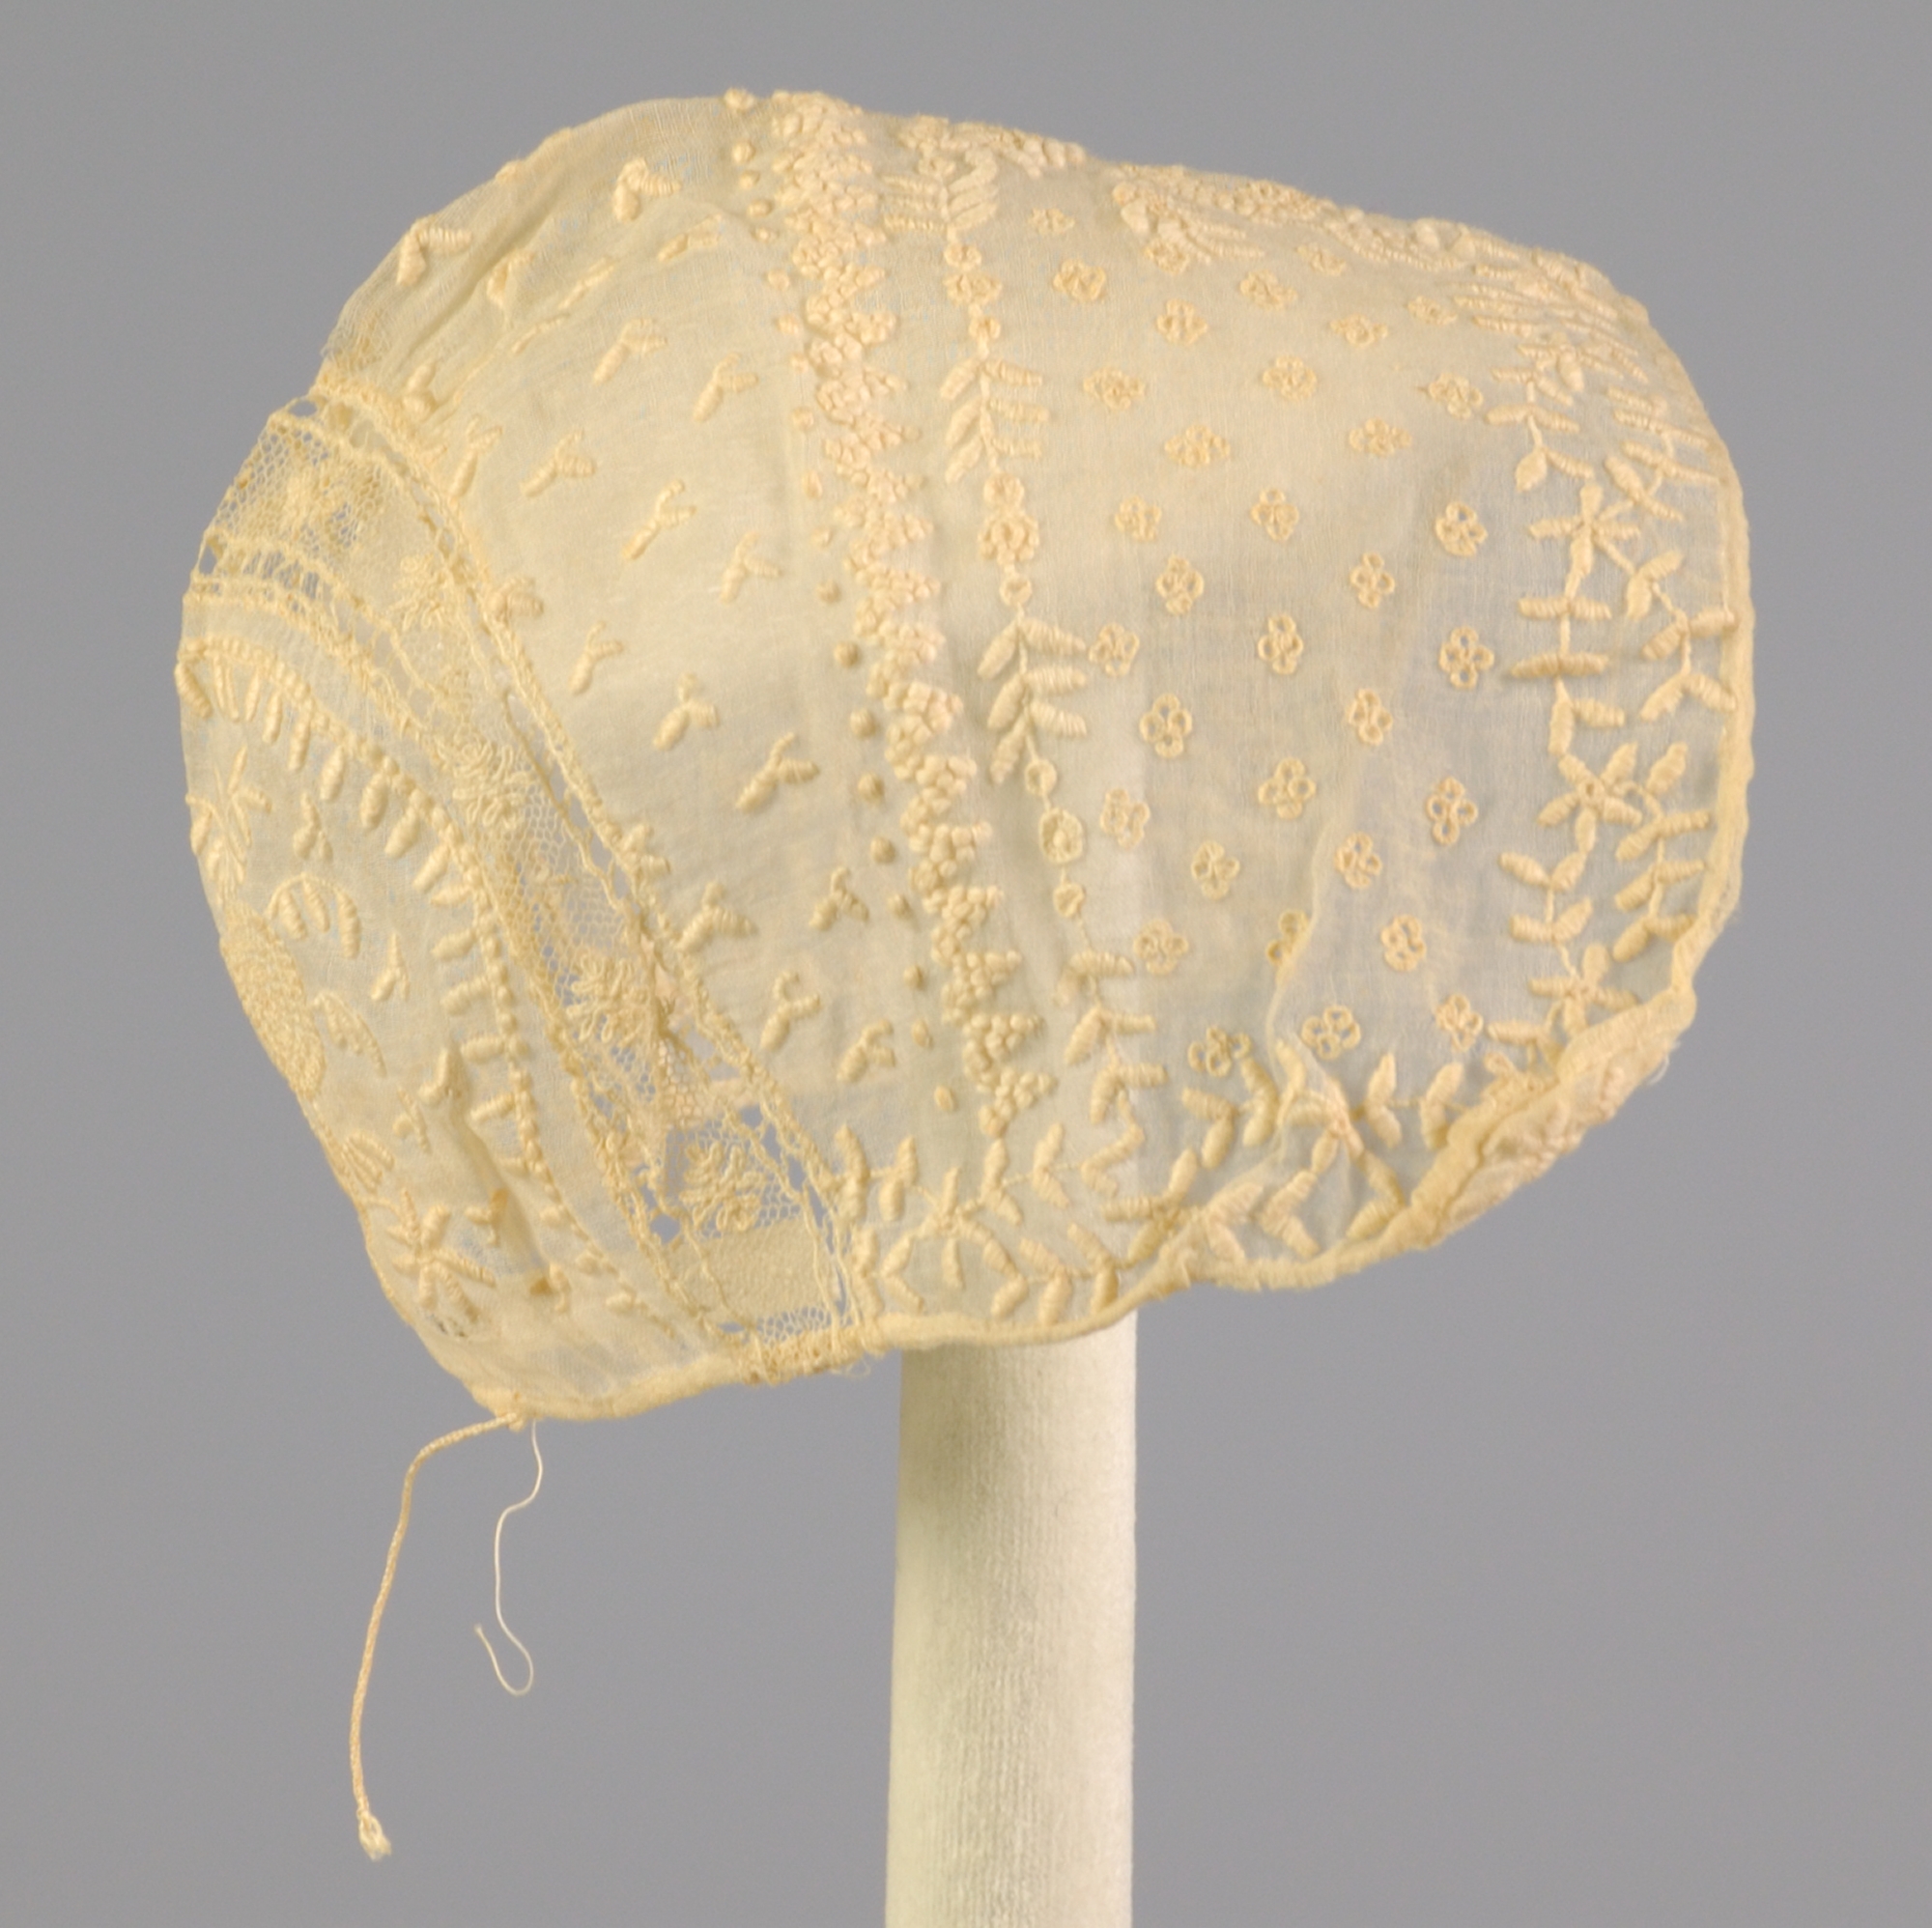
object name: cap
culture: american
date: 1840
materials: cotton